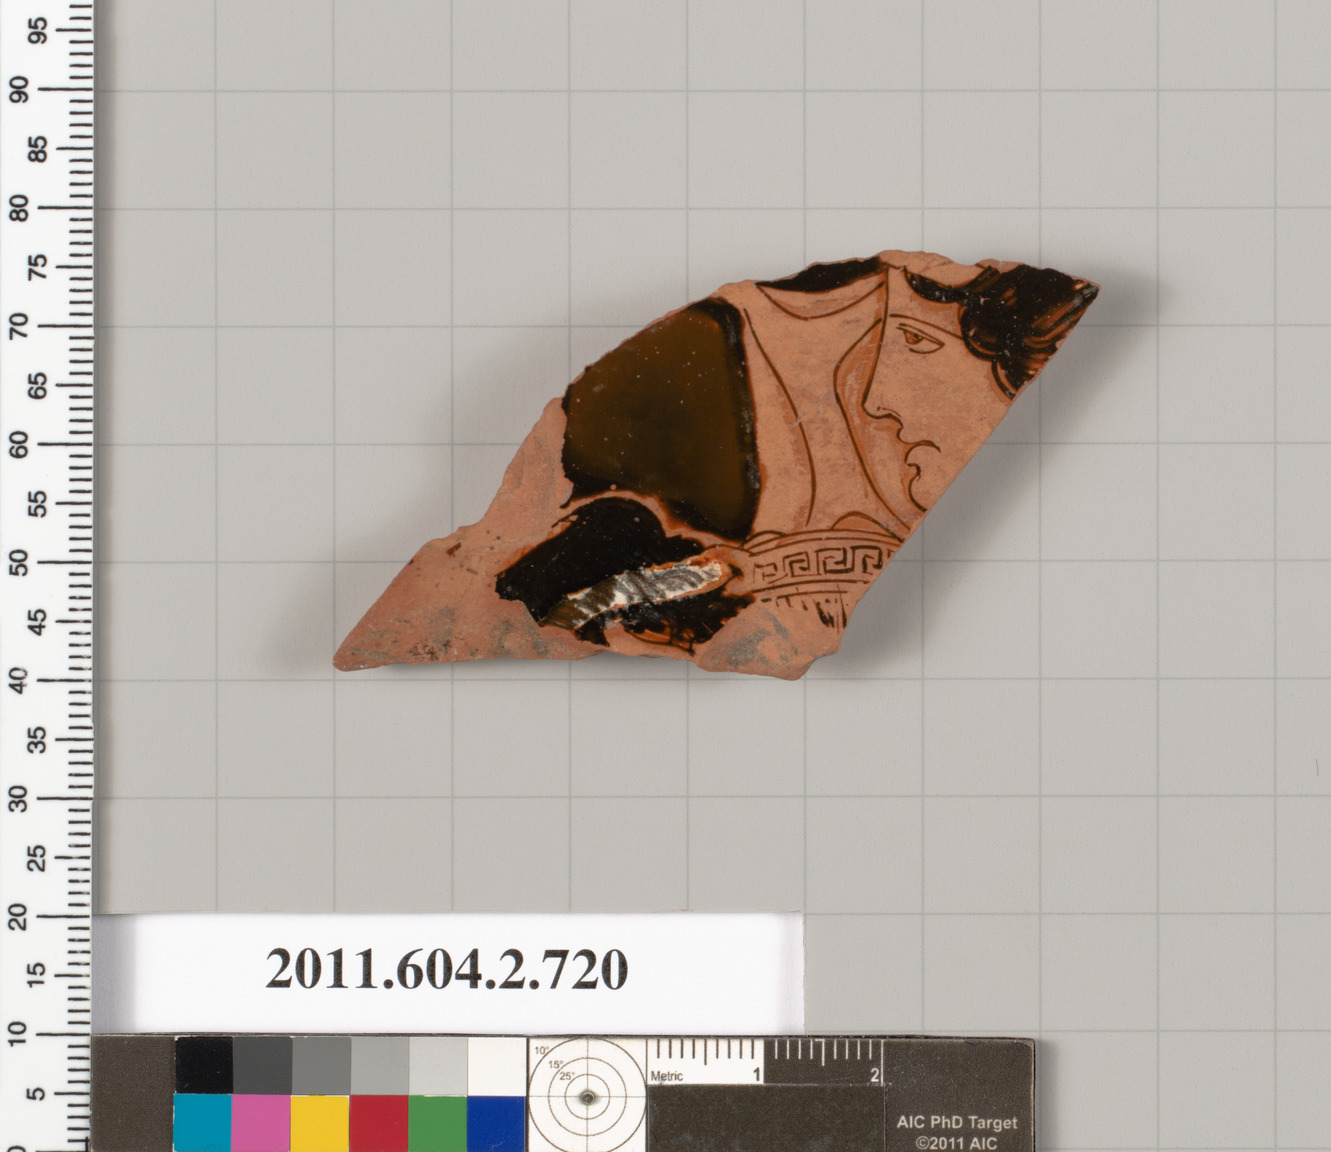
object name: calyx krater fragment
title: Terracotta fragment of a calyx-krater (bowl for mixing wine and water)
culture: greek, attic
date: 460-450 BCE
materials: terracotta